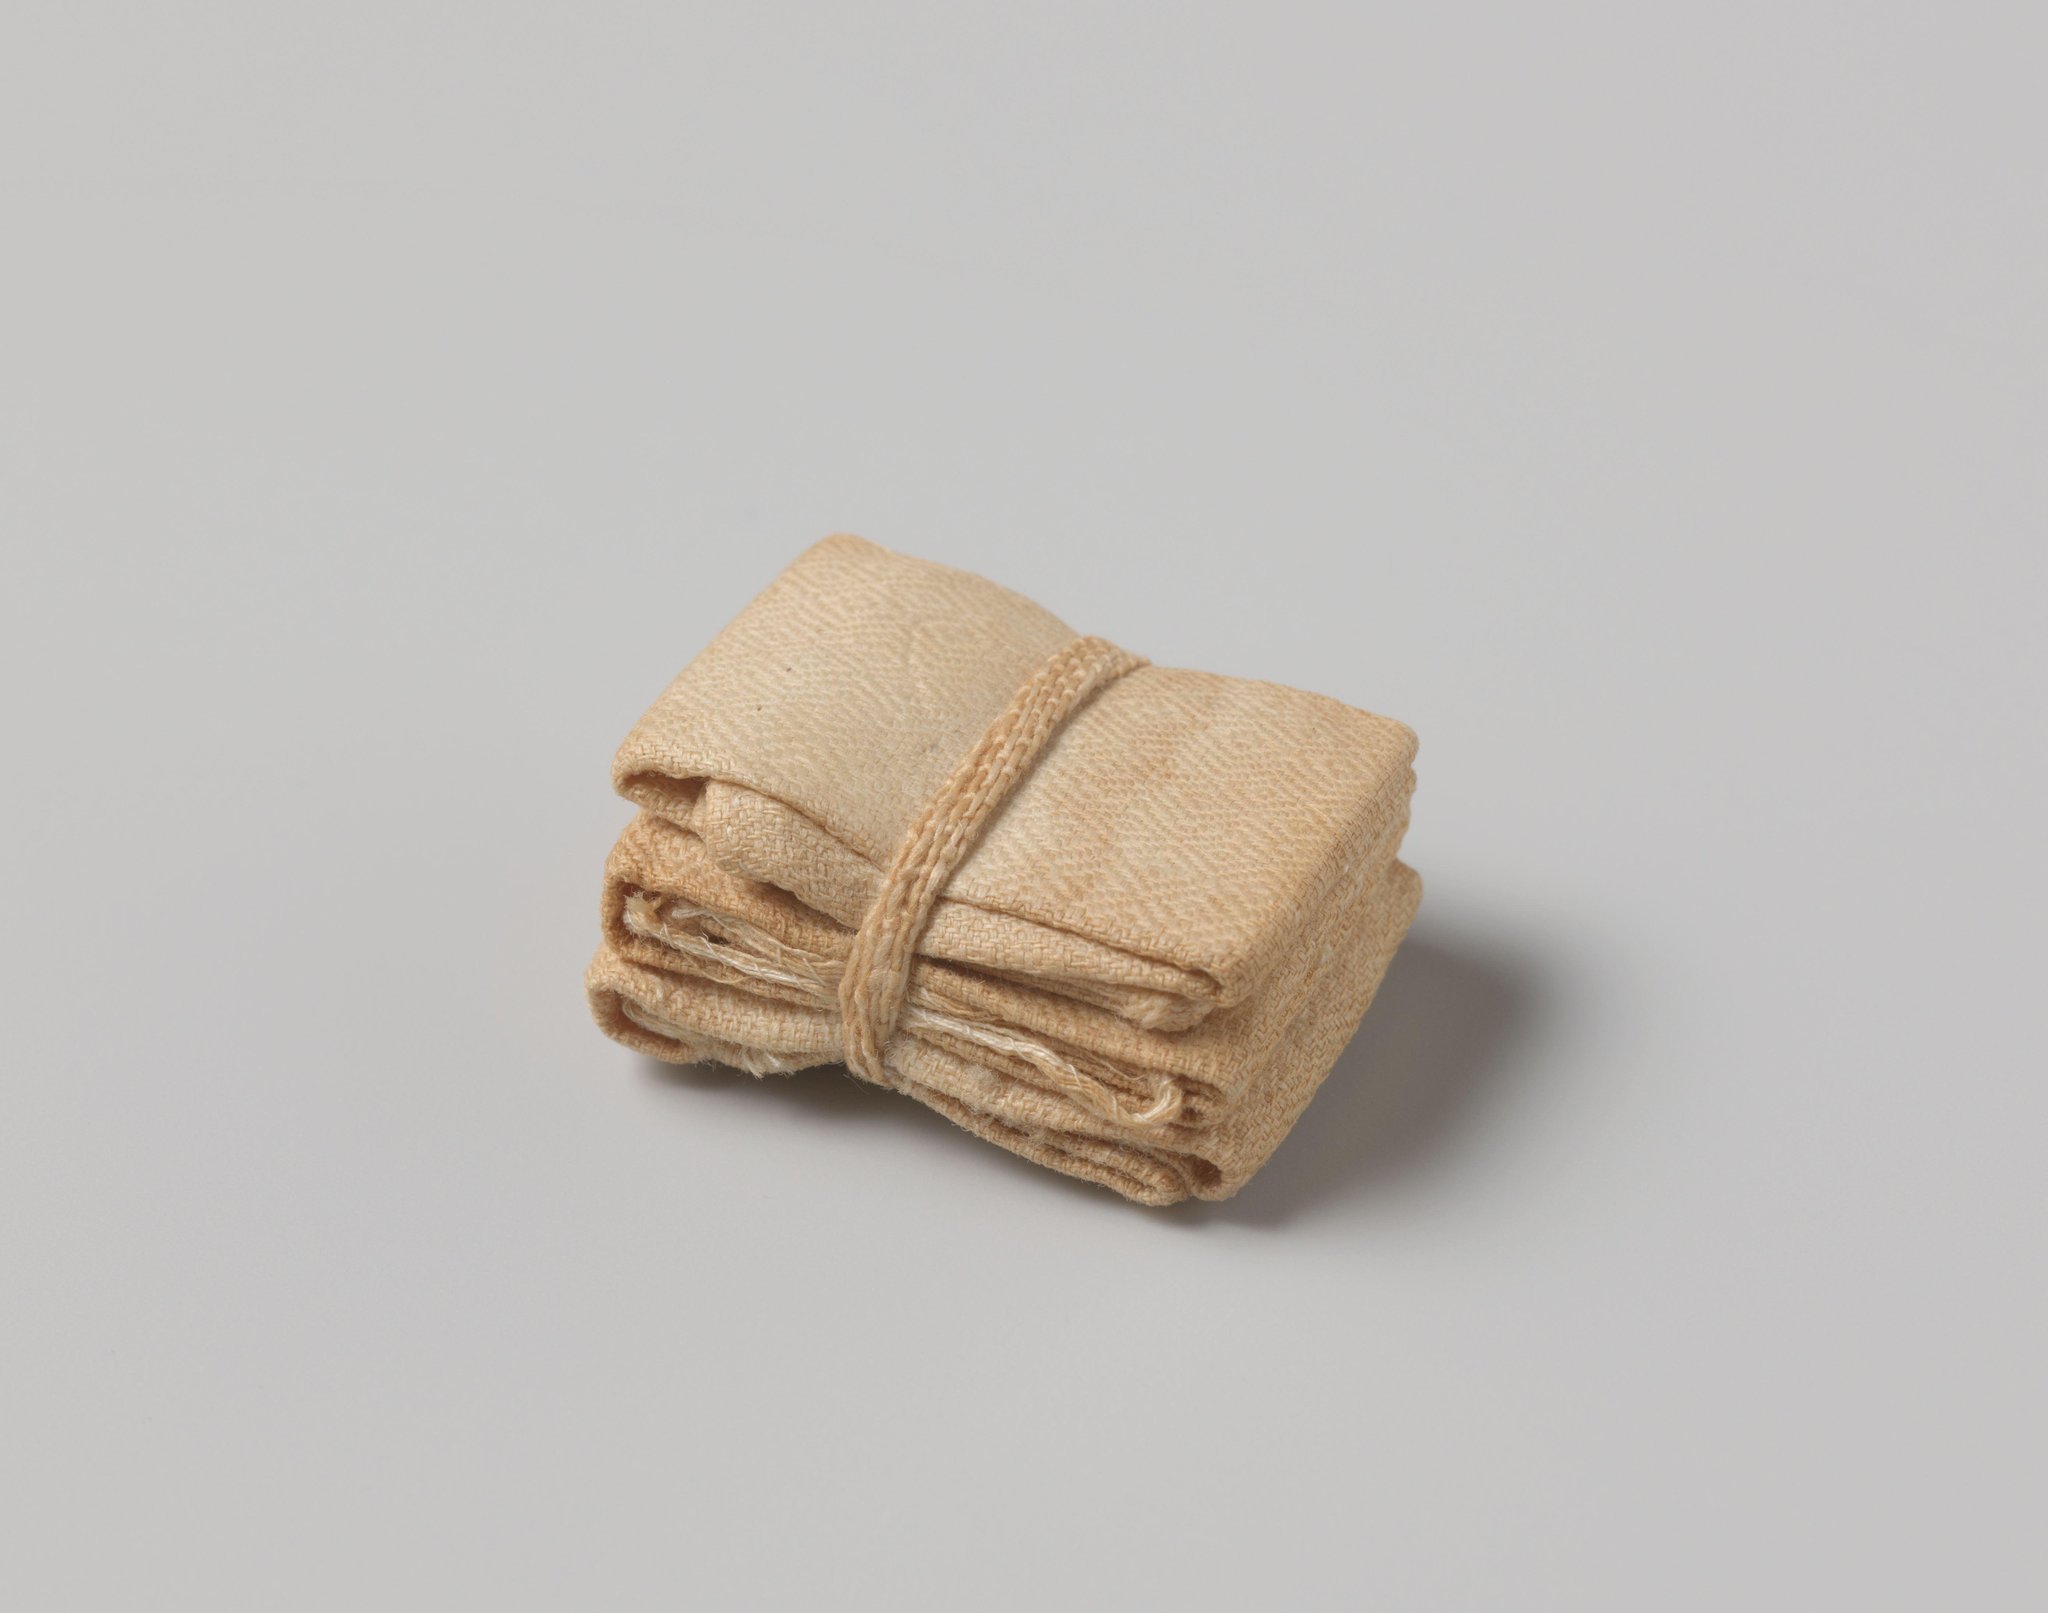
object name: napkin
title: Stapel van drie gevouwen en samengebonden servetten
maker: Anonymous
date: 1750-1800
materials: cotton, linen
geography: netherlands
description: Stapel van drie opgevouwen en met katoenen band samengebonden servetten, die ieder aan twee kanten gezoomd zijn.